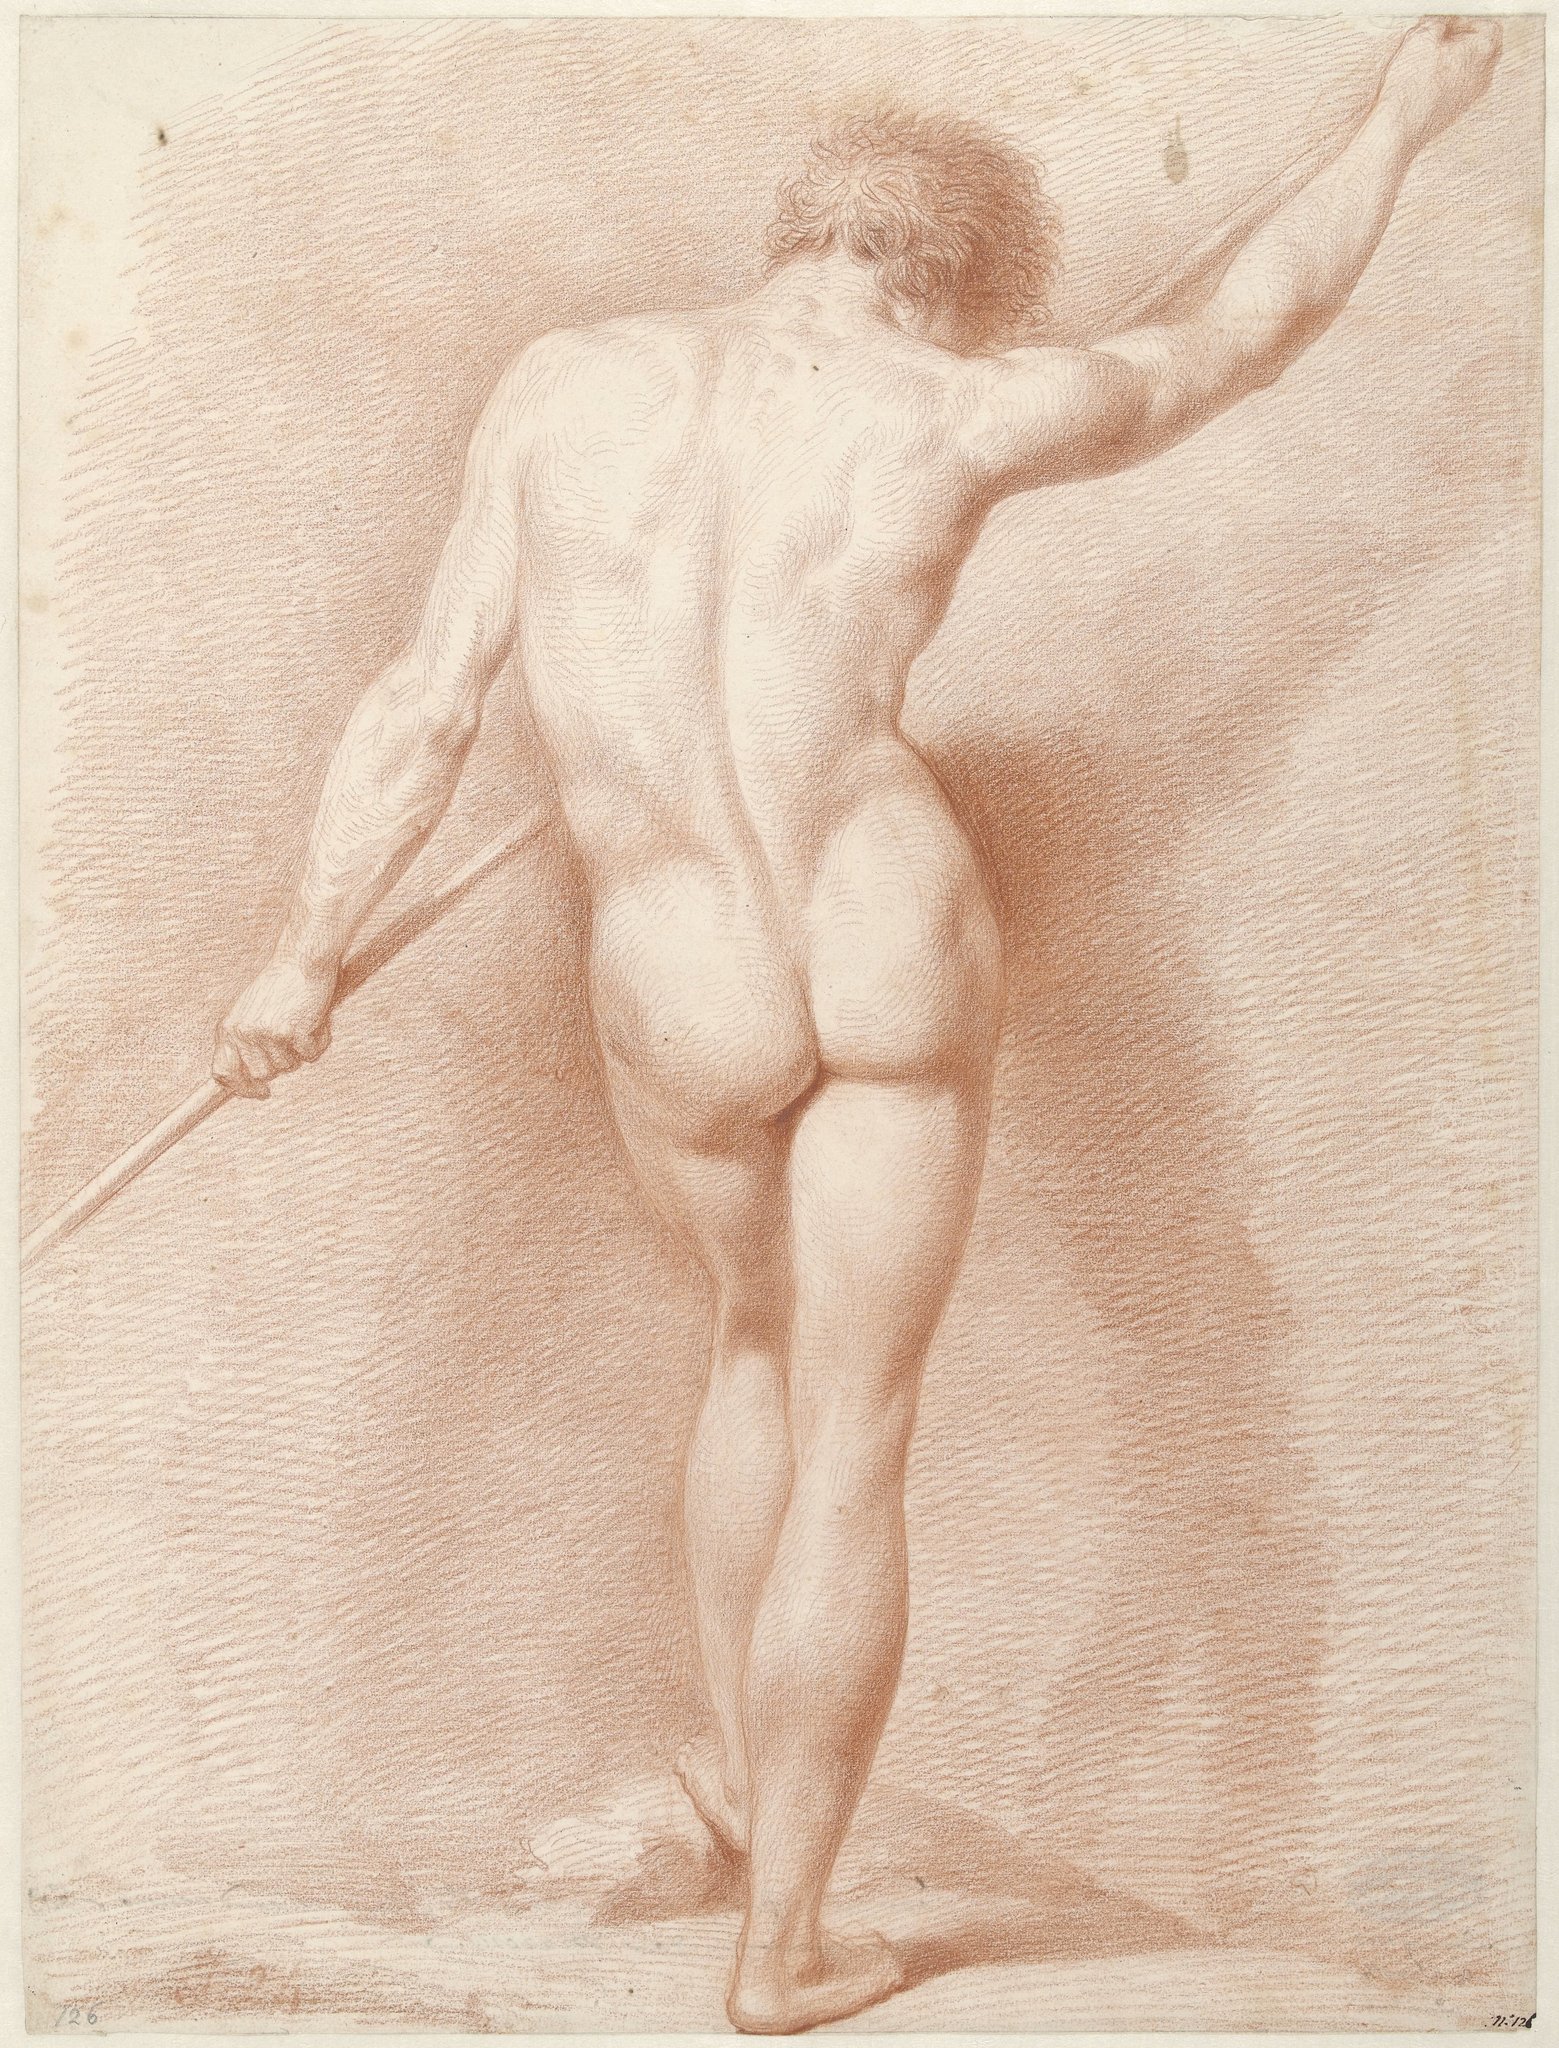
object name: drawing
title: Staand mannelijk naakt, op de rug gezien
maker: jacob ernst marcus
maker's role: draughtsman, print maker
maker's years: 1774-1826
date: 1802-1811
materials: chalk, paper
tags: standing figure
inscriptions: inscription: ‘[..] January 1803 / G: Swarth / directeur / Voor de Stelbeurt van de Heer Vrijdag maand november 1802[?] / waargenomen door Marcus’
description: Staand mannelijk naakt, op de rug gezien. No. 126.